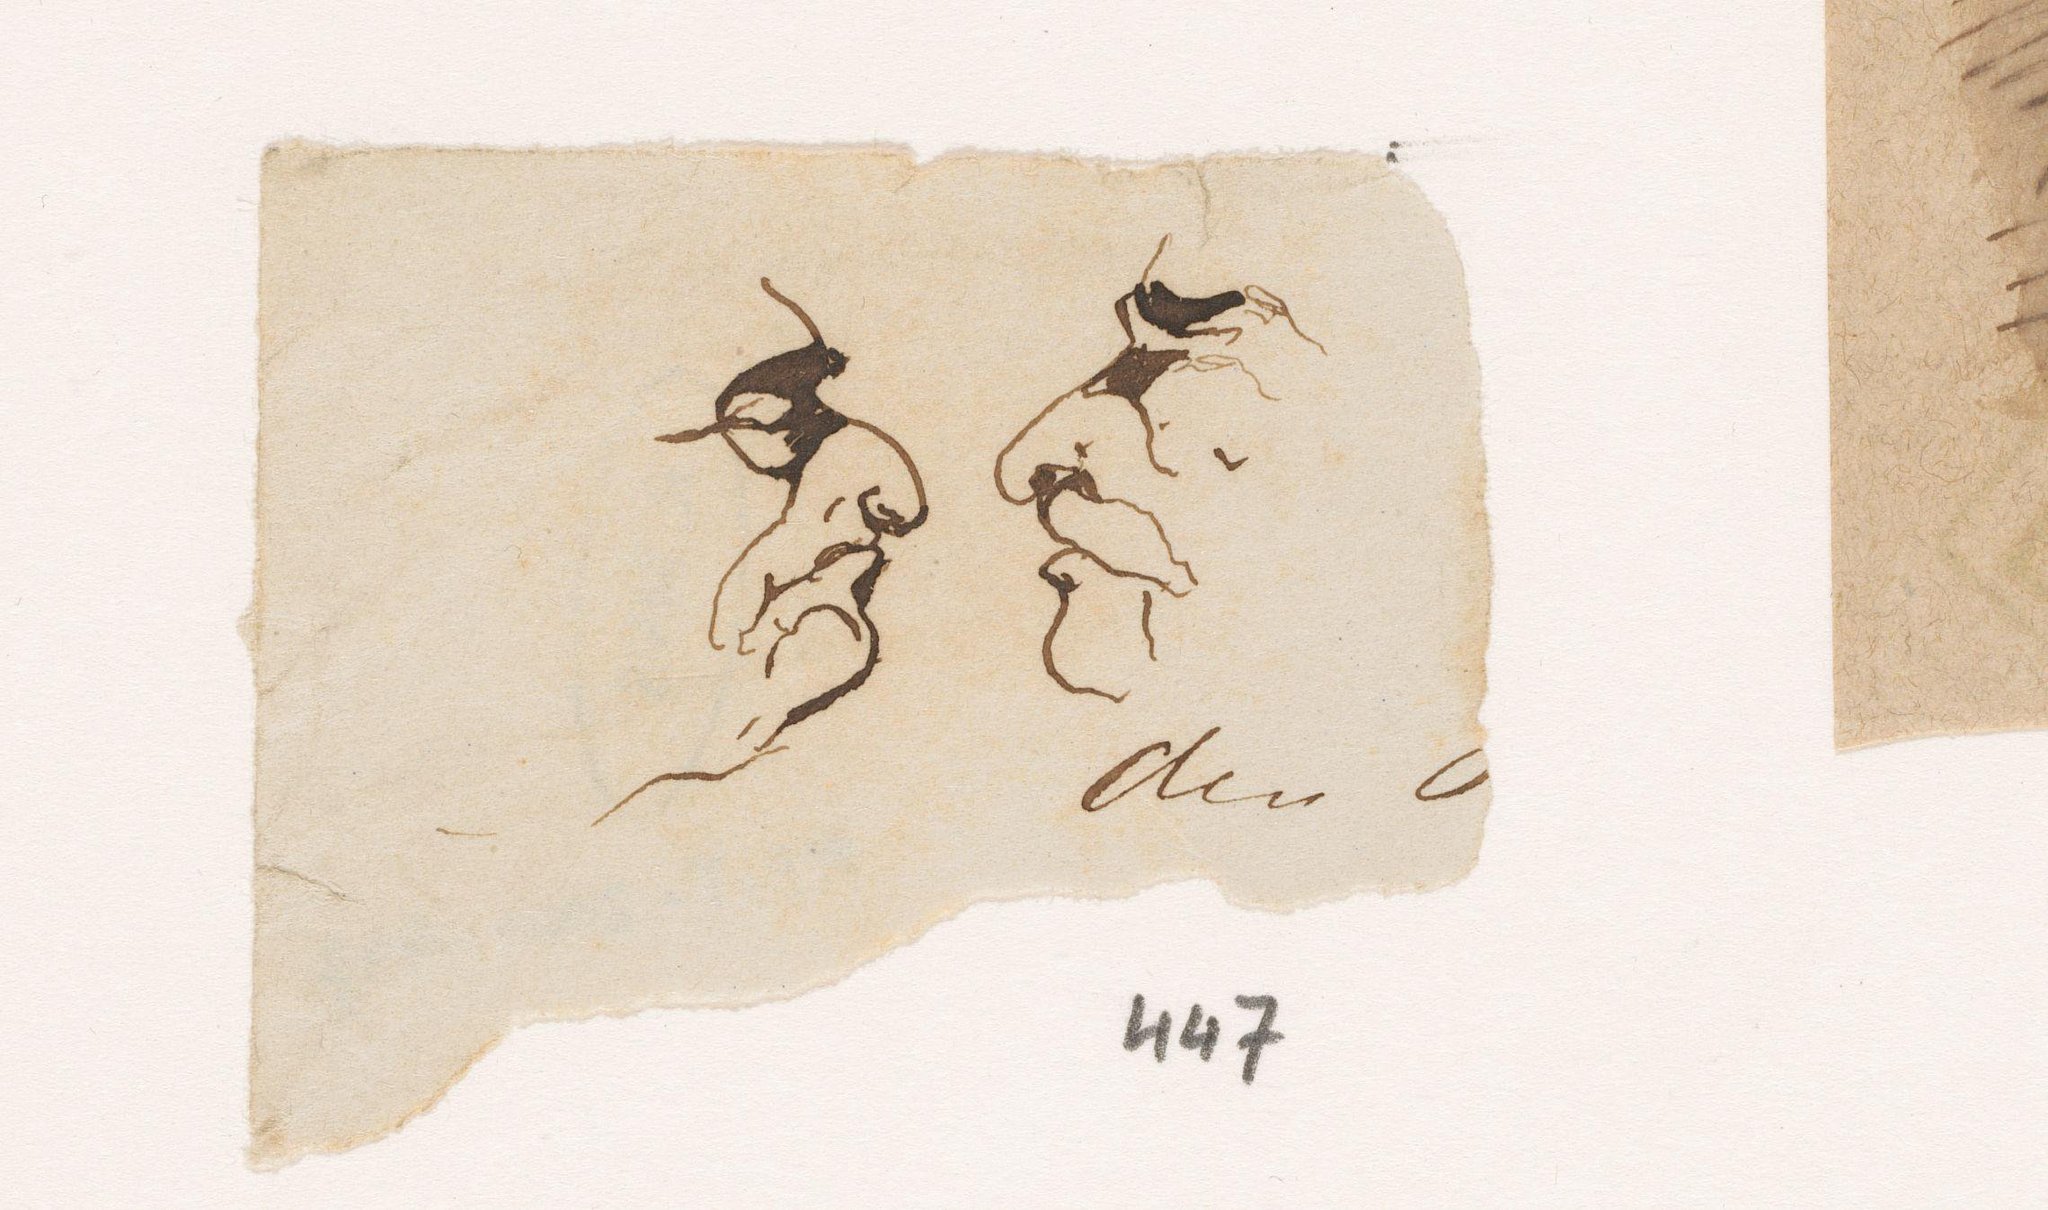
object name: drawing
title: Twee koppen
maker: johannes tavenraat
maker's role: draughtsman, painter, print maker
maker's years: 1809-1881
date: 1840-1880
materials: ink, paper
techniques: pen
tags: caricatures (human types)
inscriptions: collector's mark: Lugt 2228